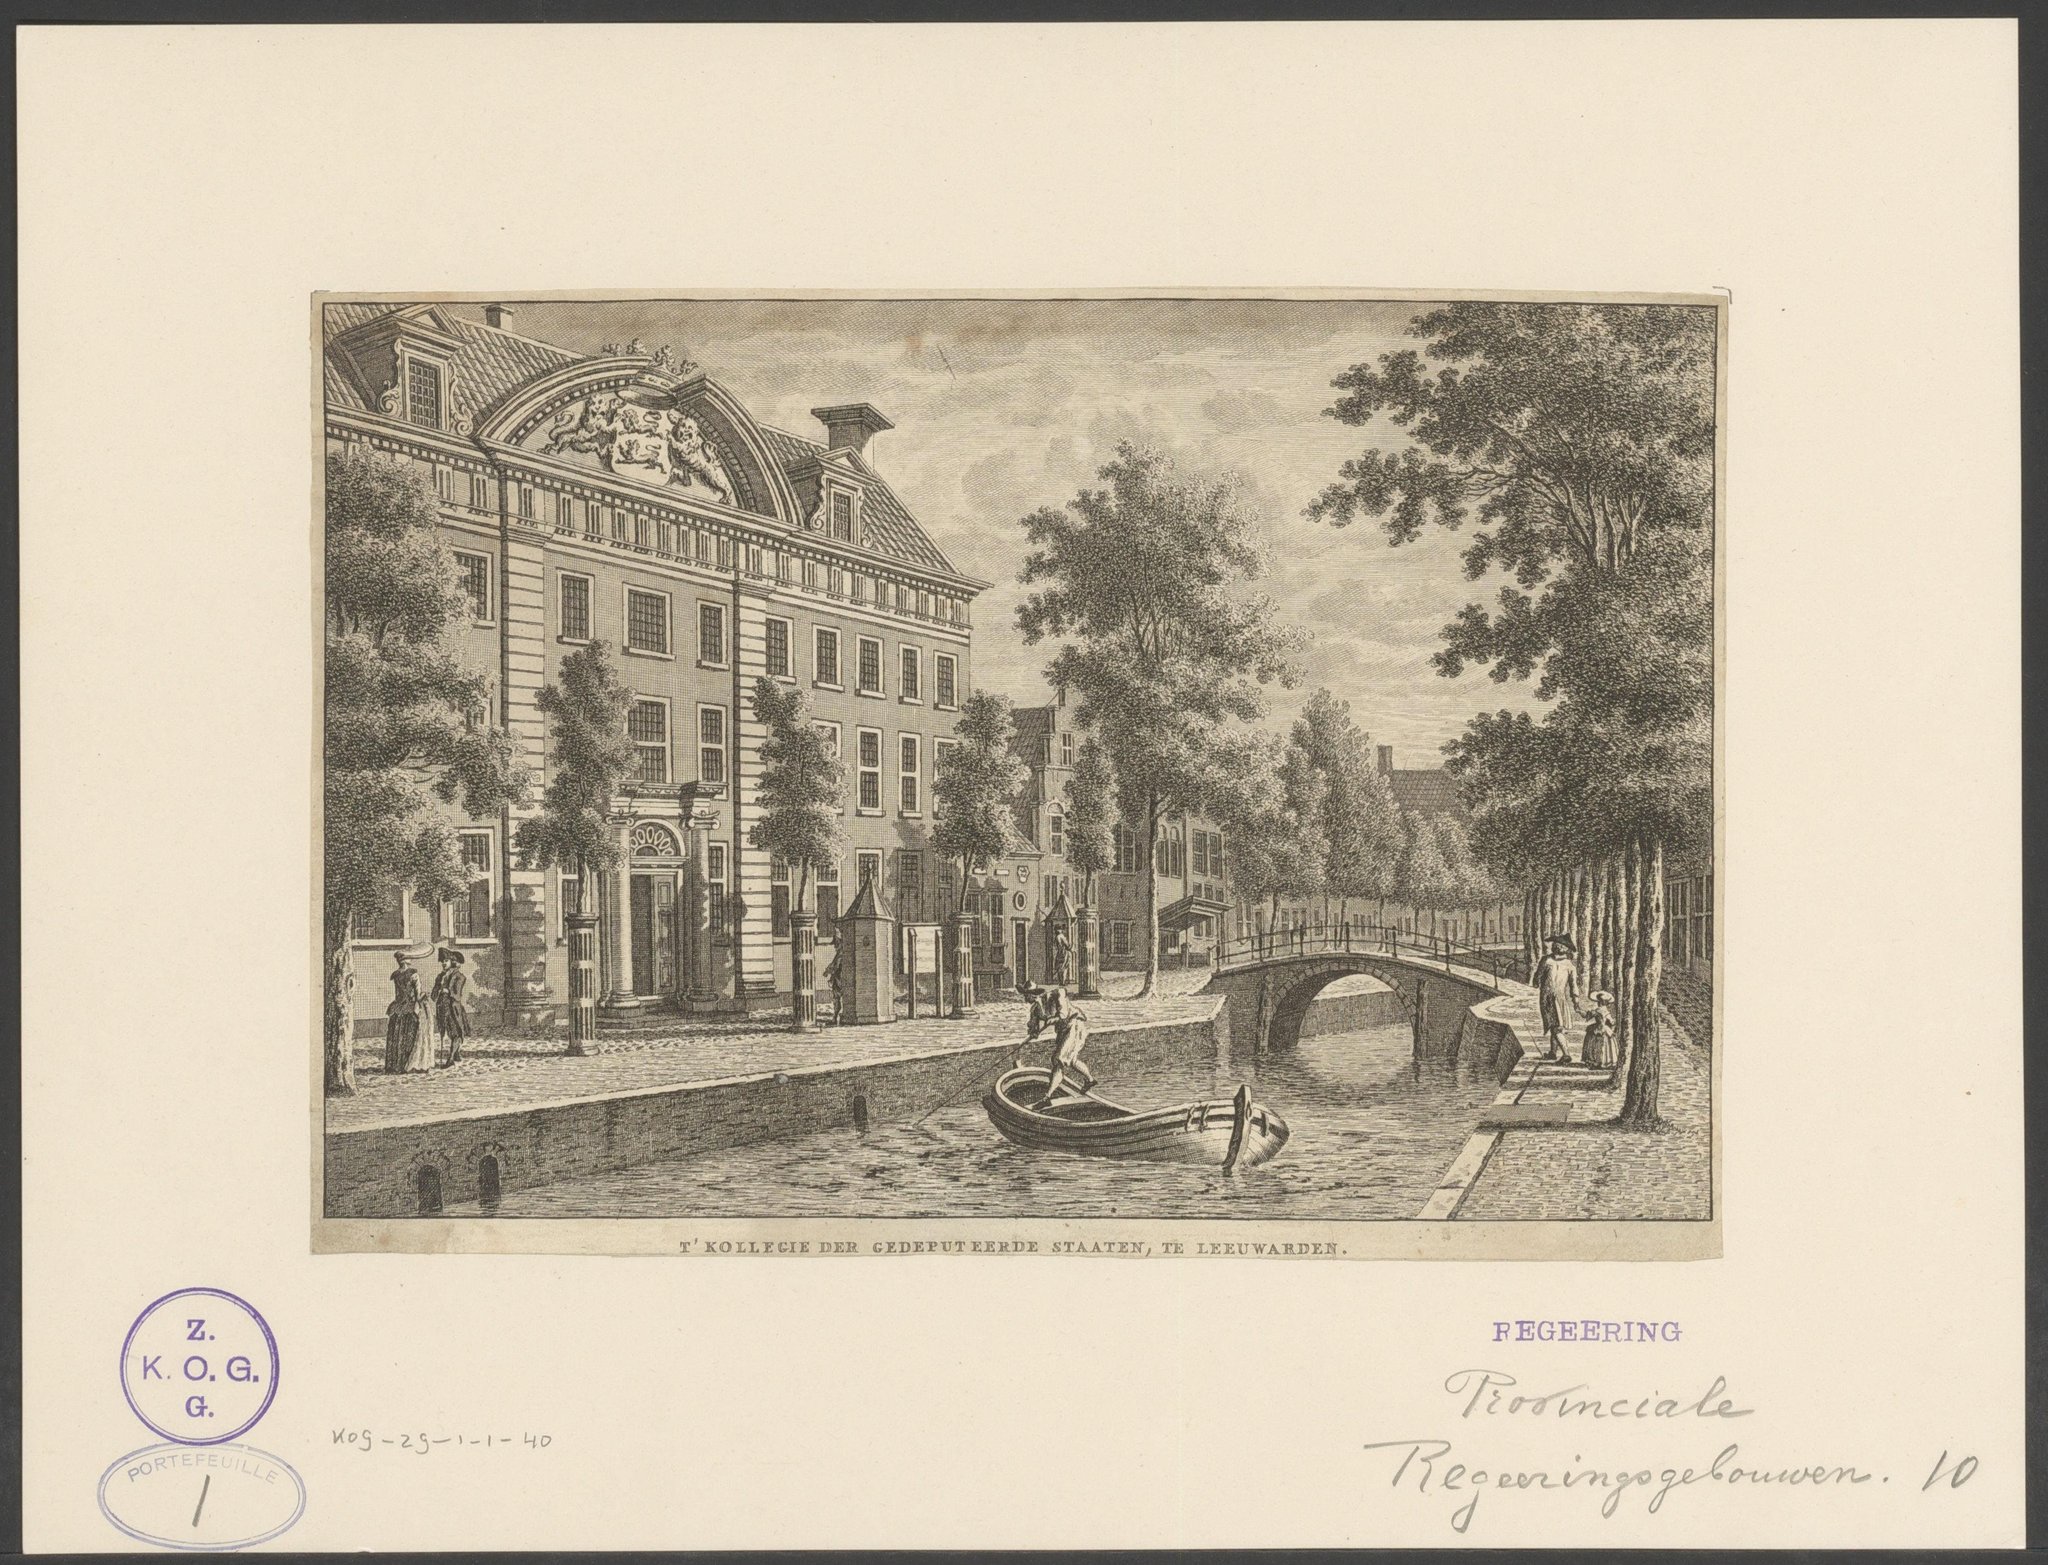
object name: print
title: T'Kollegie der Gedeputeerde Staaten, te Leeuwarden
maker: carel frederik bendorp (i)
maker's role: print maker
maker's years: 1736-1814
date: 1786-1792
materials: paper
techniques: etching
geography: netherlands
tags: provincial government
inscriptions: collector's mark: Lugt 1641, collector's mark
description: Prent uit: Vaderlandsche gezichten, of afbeeldingen van den tegenwoordigen staat der Vereenigde Nederlanden (…). Amsterdam: Hendrik Gartman, Willem Vermandel en Jan Willem Smit, 1786-1792. Uitgegeven in afleveringen met ieder een eigen bifolium en inhoudsopgave. Alle prenten in deze publicatie zijn gegraveerd door Carel Frederik Bendorp (I) en, in de meeste gevallen, gebaseerd op tekeningen van Jan Bulthuis.